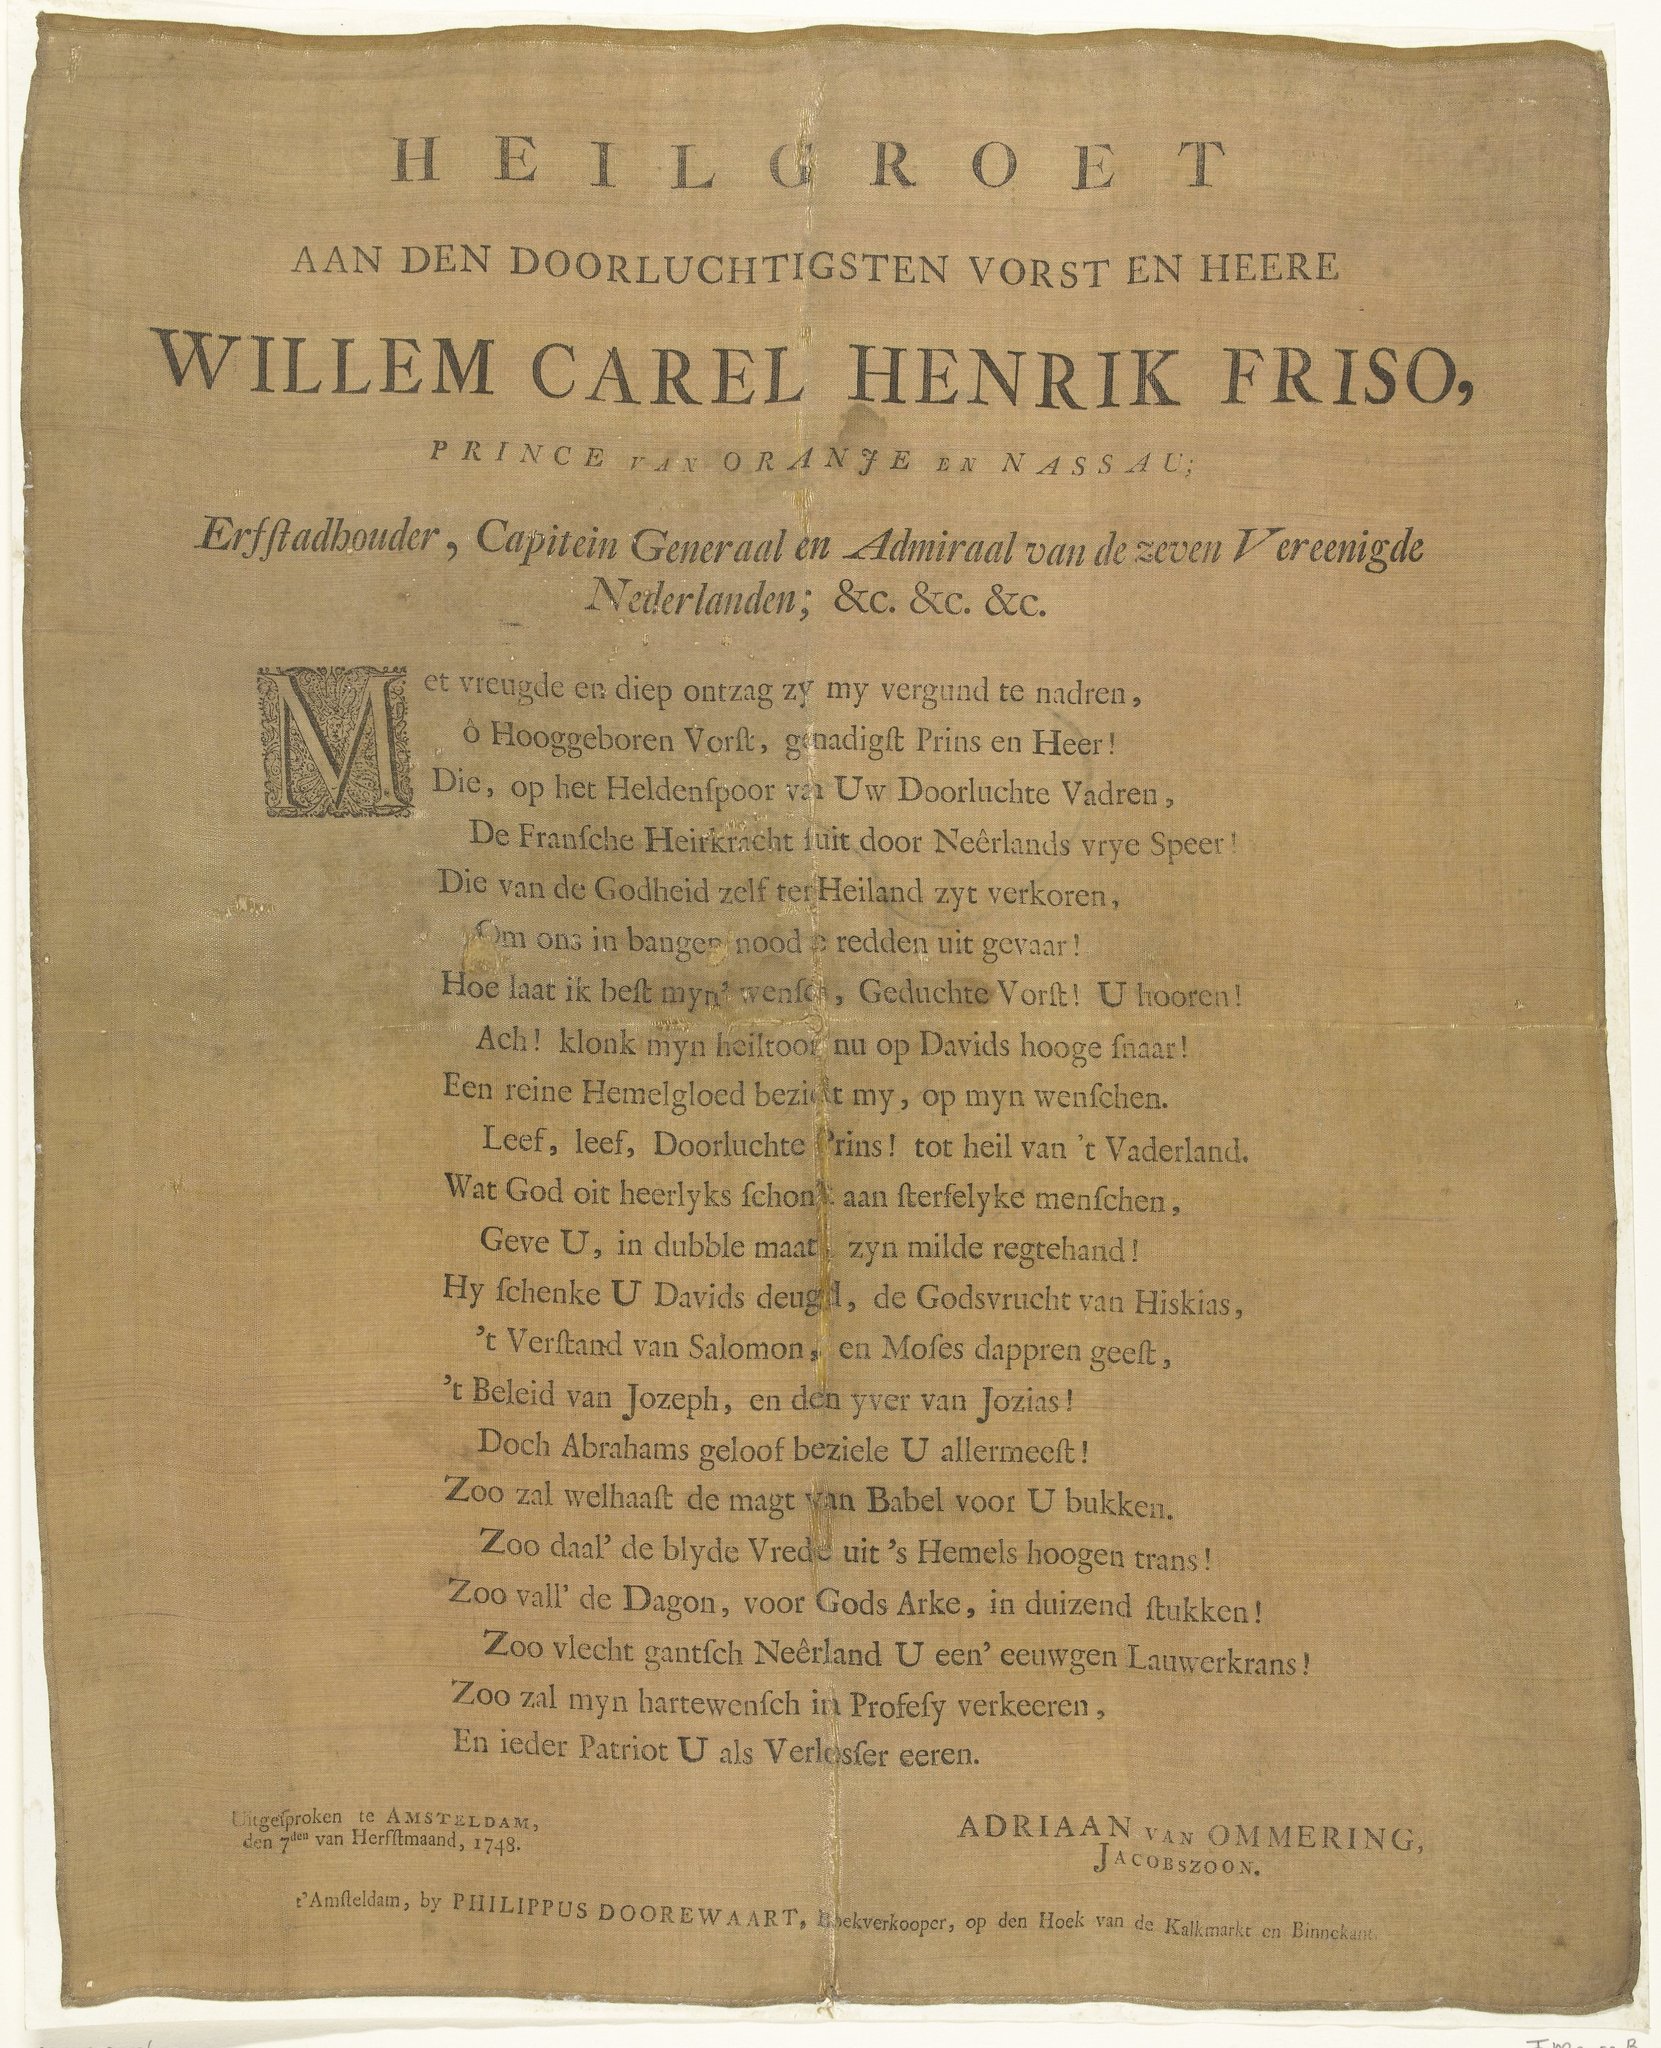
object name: text sheet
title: Heilgroet aan den doorluchtigsteen vorst en heere Willem Carel Henrik Friso, Prince van Oranje en Nassau (...)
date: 1748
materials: silk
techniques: letterpress printing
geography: amsterdam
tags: the hague, willem iv (prins van oranje-nassau), amsterdam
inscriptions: collector's mark: Lugt 2228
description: Heilgroet uitgebracht aan prins Willem IV bij zijn bezoek aan Amsterdam, uitgesproken op 7 september 1748. Vers van 22 regels.